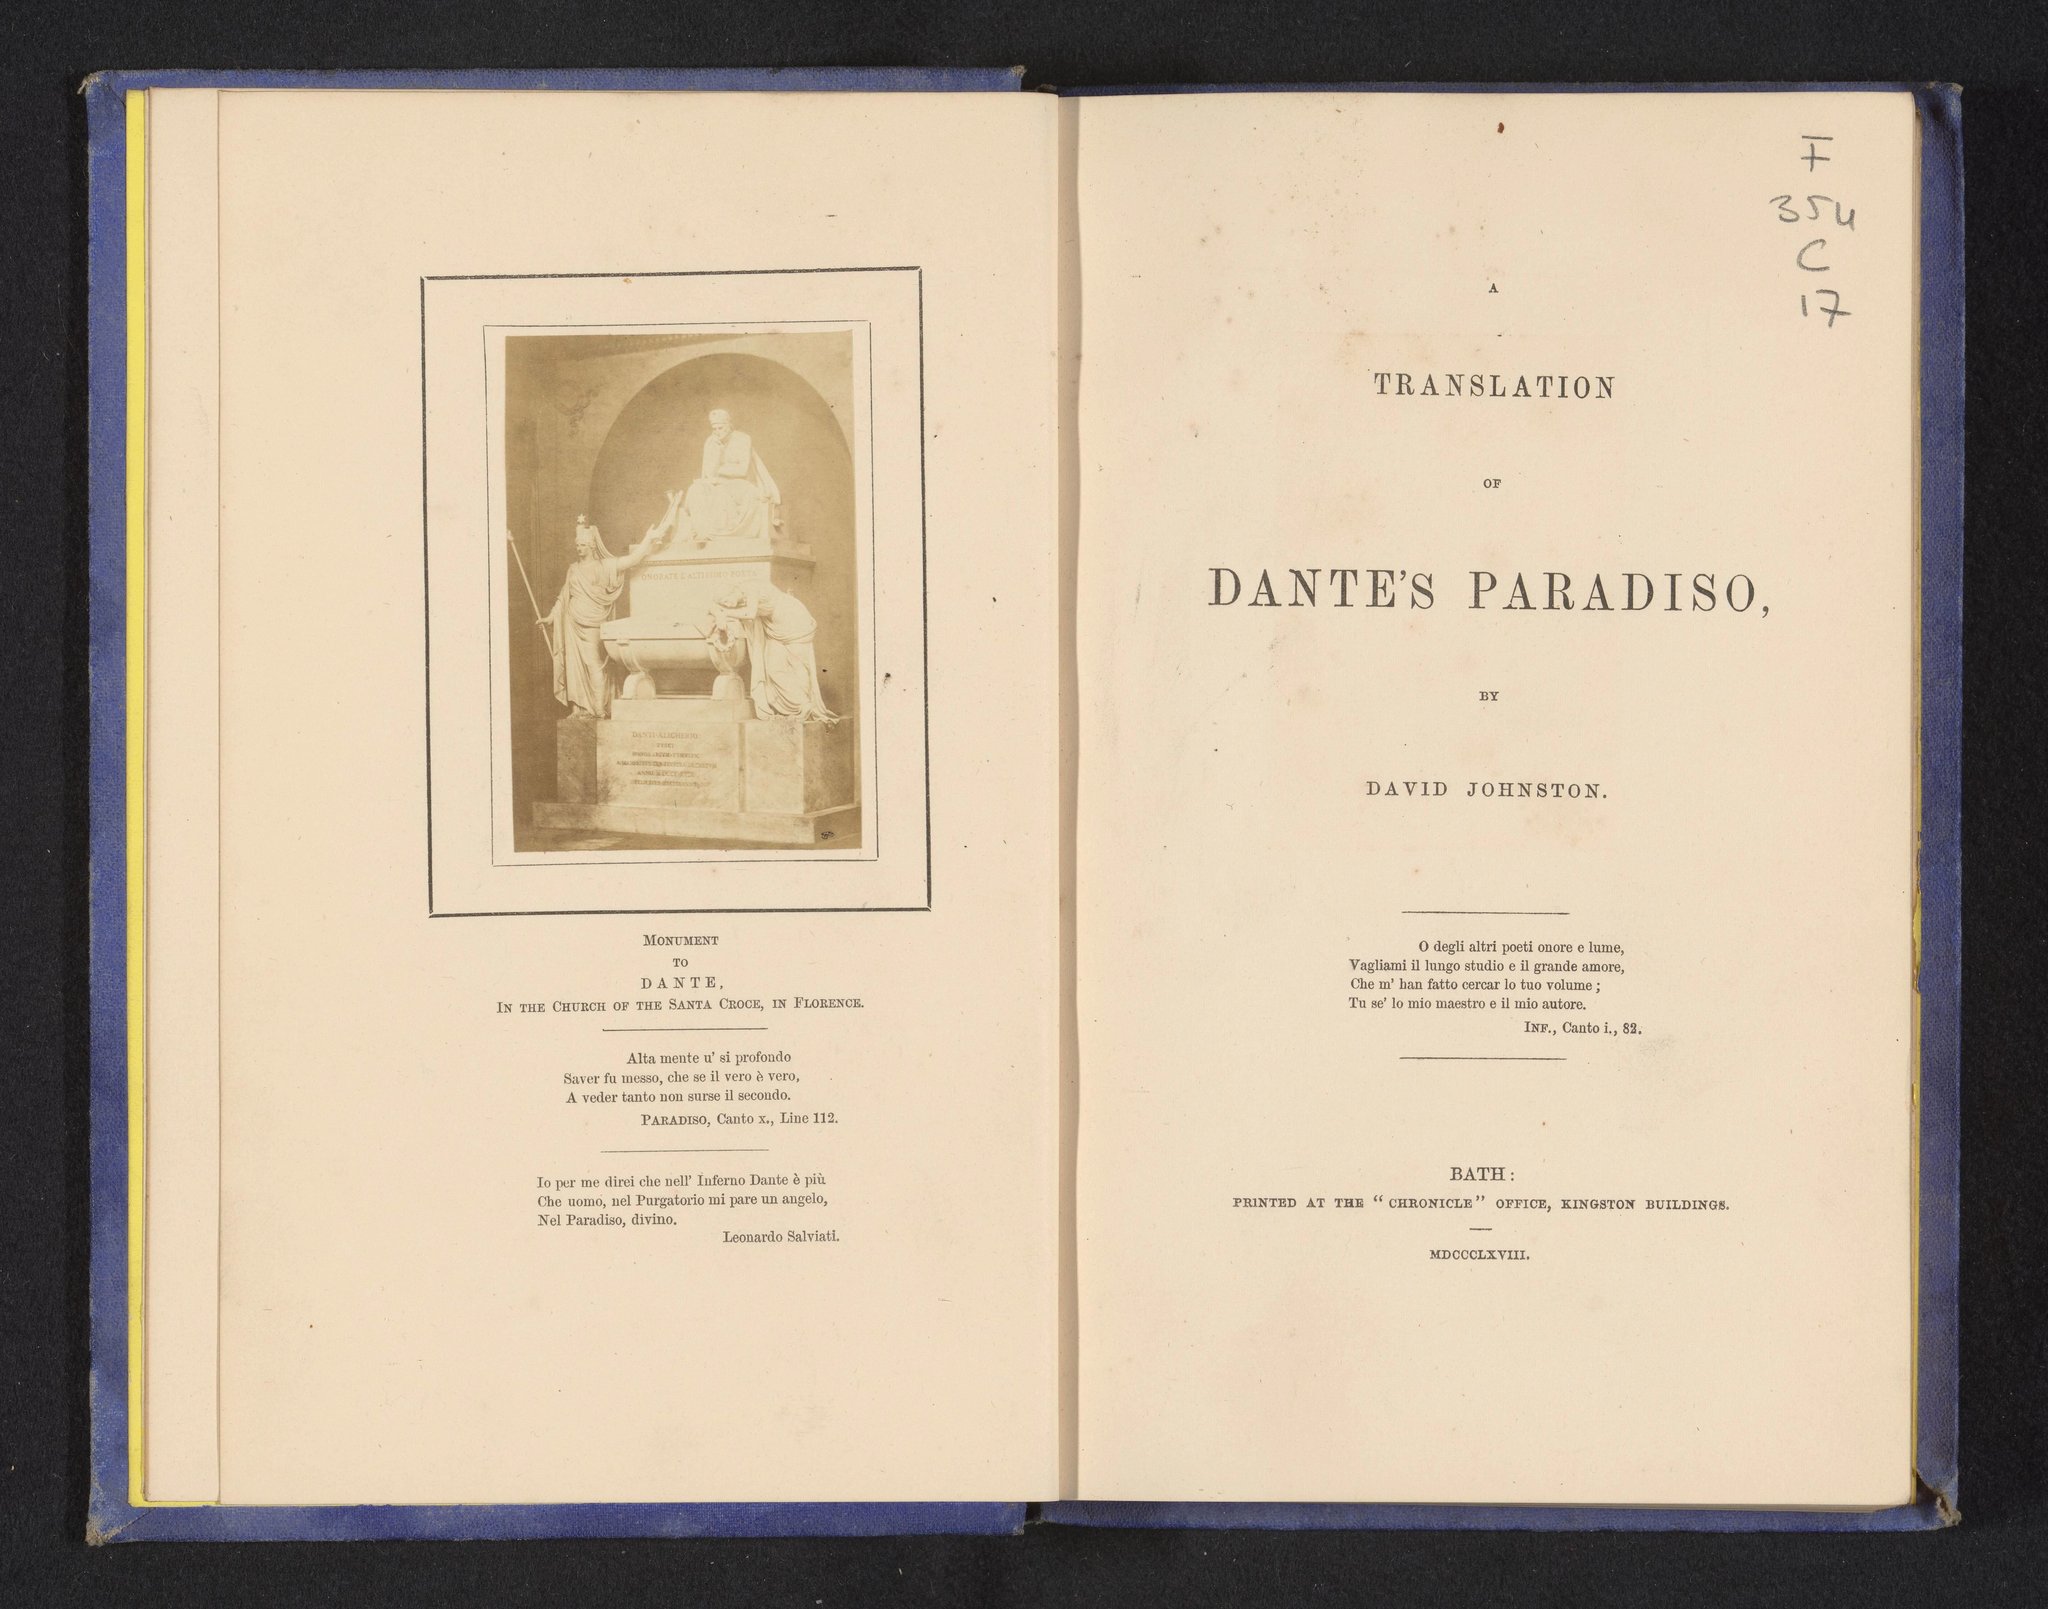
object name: photograph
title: Monument to Dante, in the Church of the Santa Croce, in Florence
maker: Anonymous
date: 1858-1868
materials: photographic support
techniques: albumen print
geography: santa croce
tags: dante alighieri, grave, tomb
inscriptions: inscription: ‘Alta mente u'si profondo Saver fu messo, che se il vero è vero, A veder tanto non surse il secondo. Paradiso, Canto x., Line 112. Io per me direi che nell' Inferno Dante è più Che uomo, nel Purgatorio mi pare un angelo, Nel Paradiso, divino. Leonardo Salviati.’